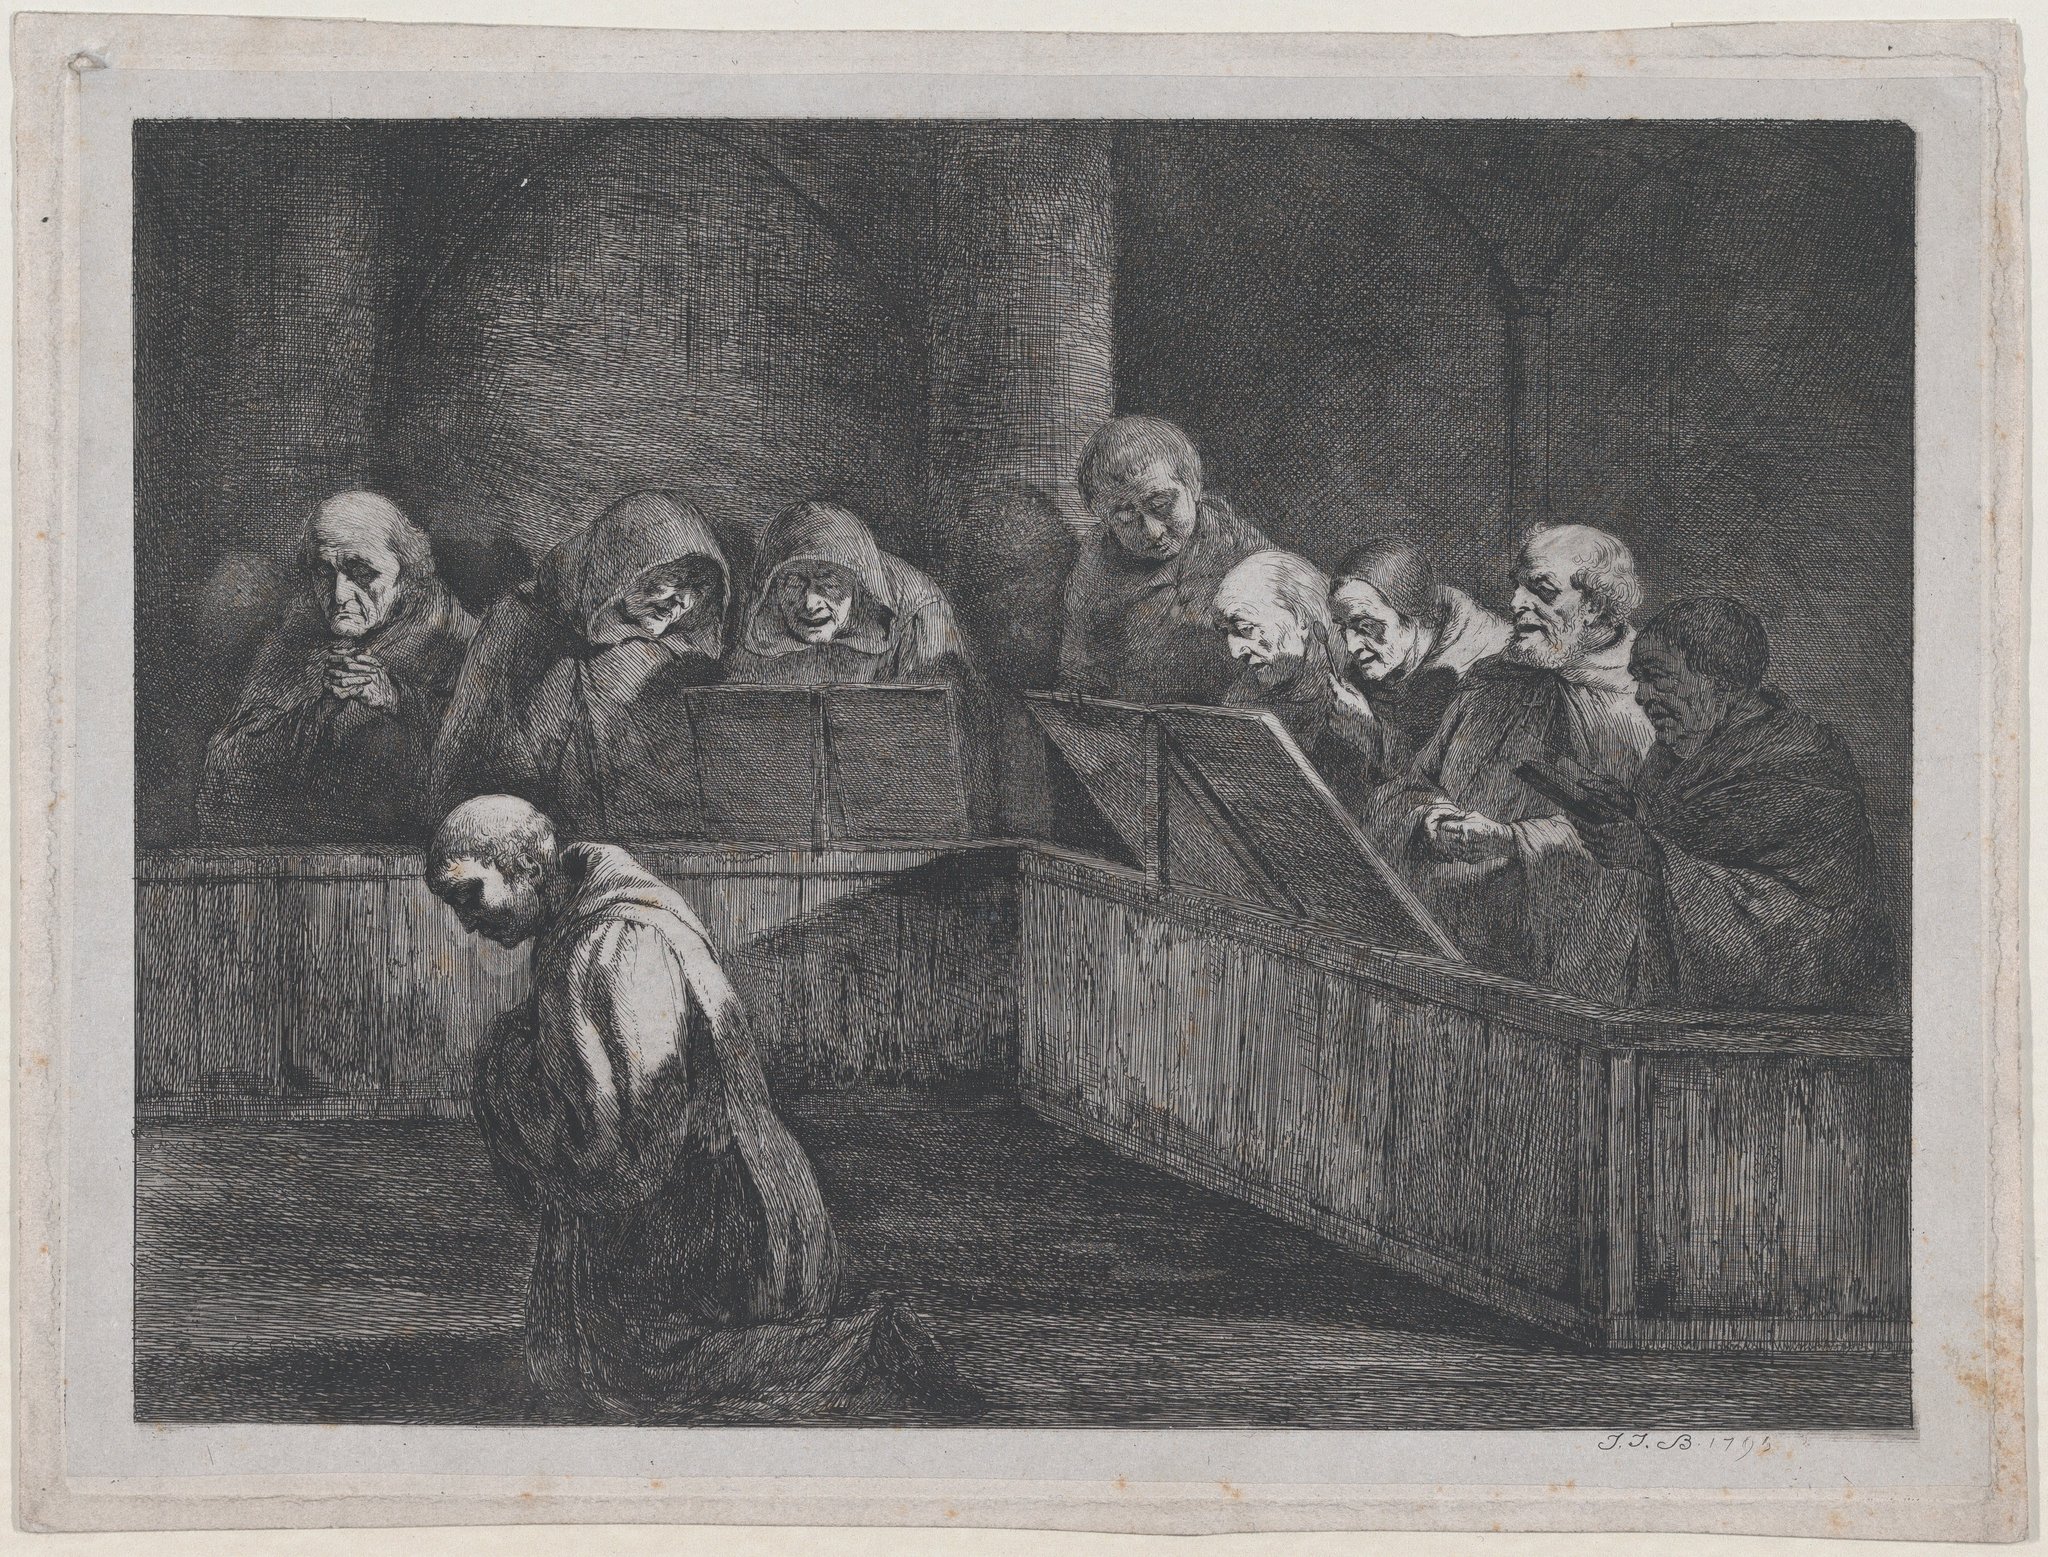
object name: print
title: Monks Chanting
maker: jean jacques de boissieu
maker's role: artist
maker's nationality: french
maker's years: 1736-1810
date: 1795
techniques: drypoint, etching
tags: monks